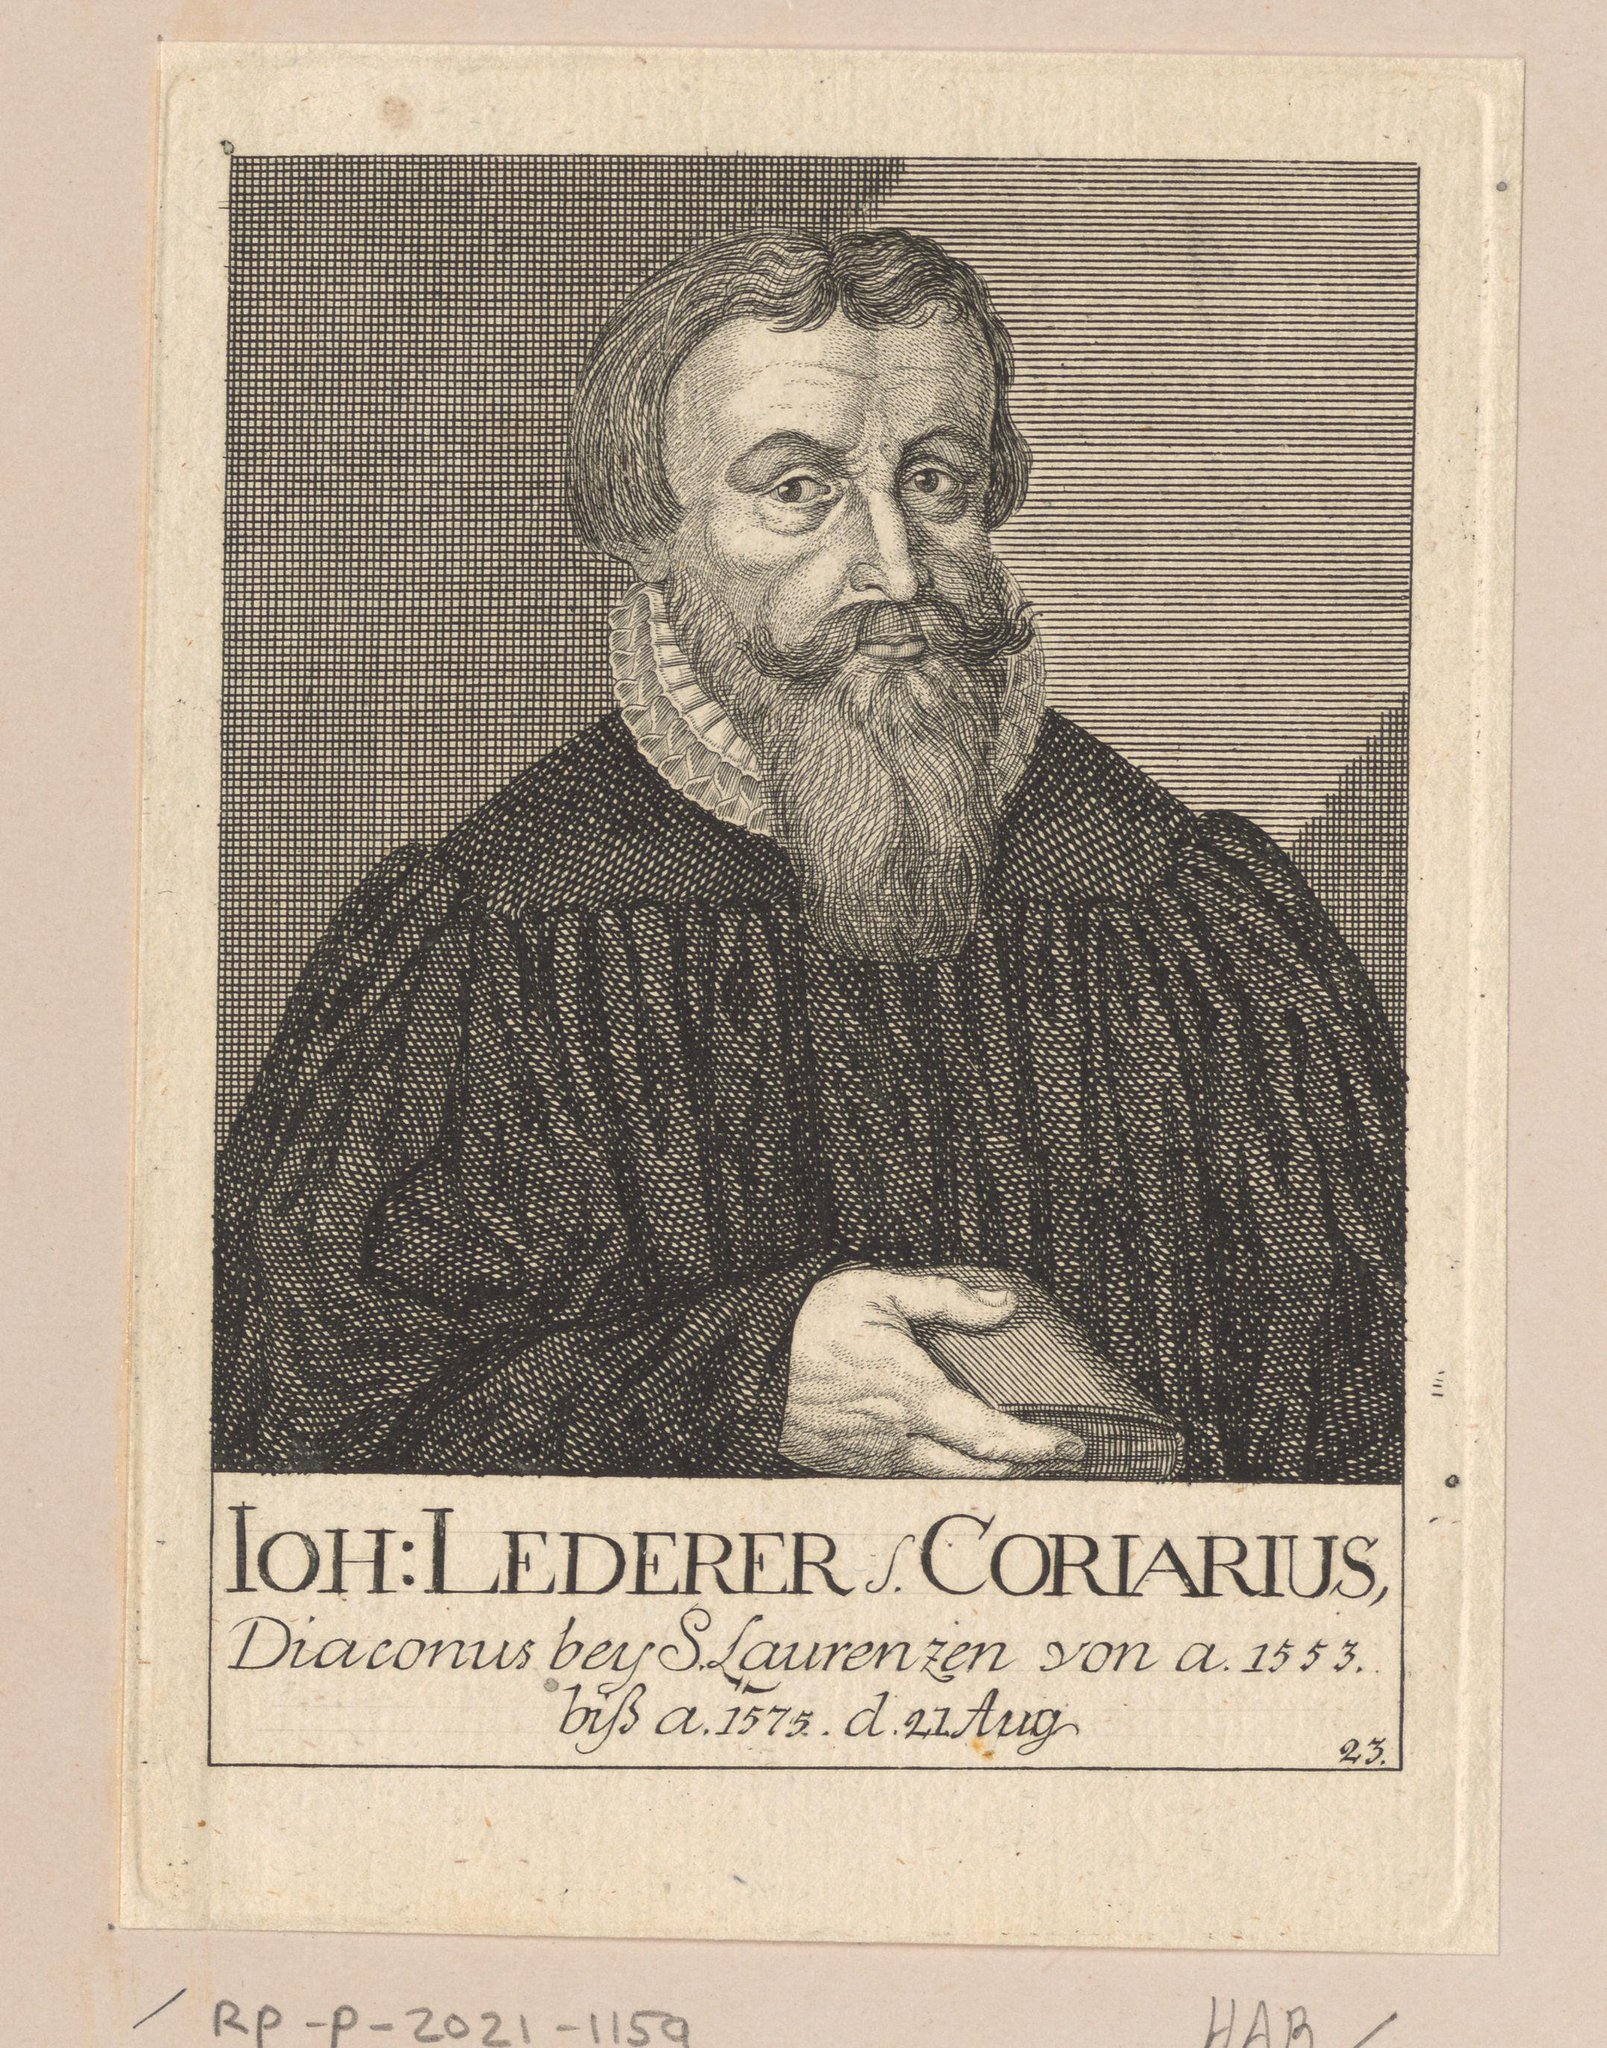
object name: print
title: Portret van Johannes Lederer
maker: Anonymous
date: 1756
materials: paper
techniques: engraving, etching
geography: germany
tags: clergyman, historical persons, book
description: Prent waarschijnlijk uit: Würfel, Andreas. Diptycha ecclesiae Laurentianae (...). Neurenberg: Christoph Melchior Roth, 1756.